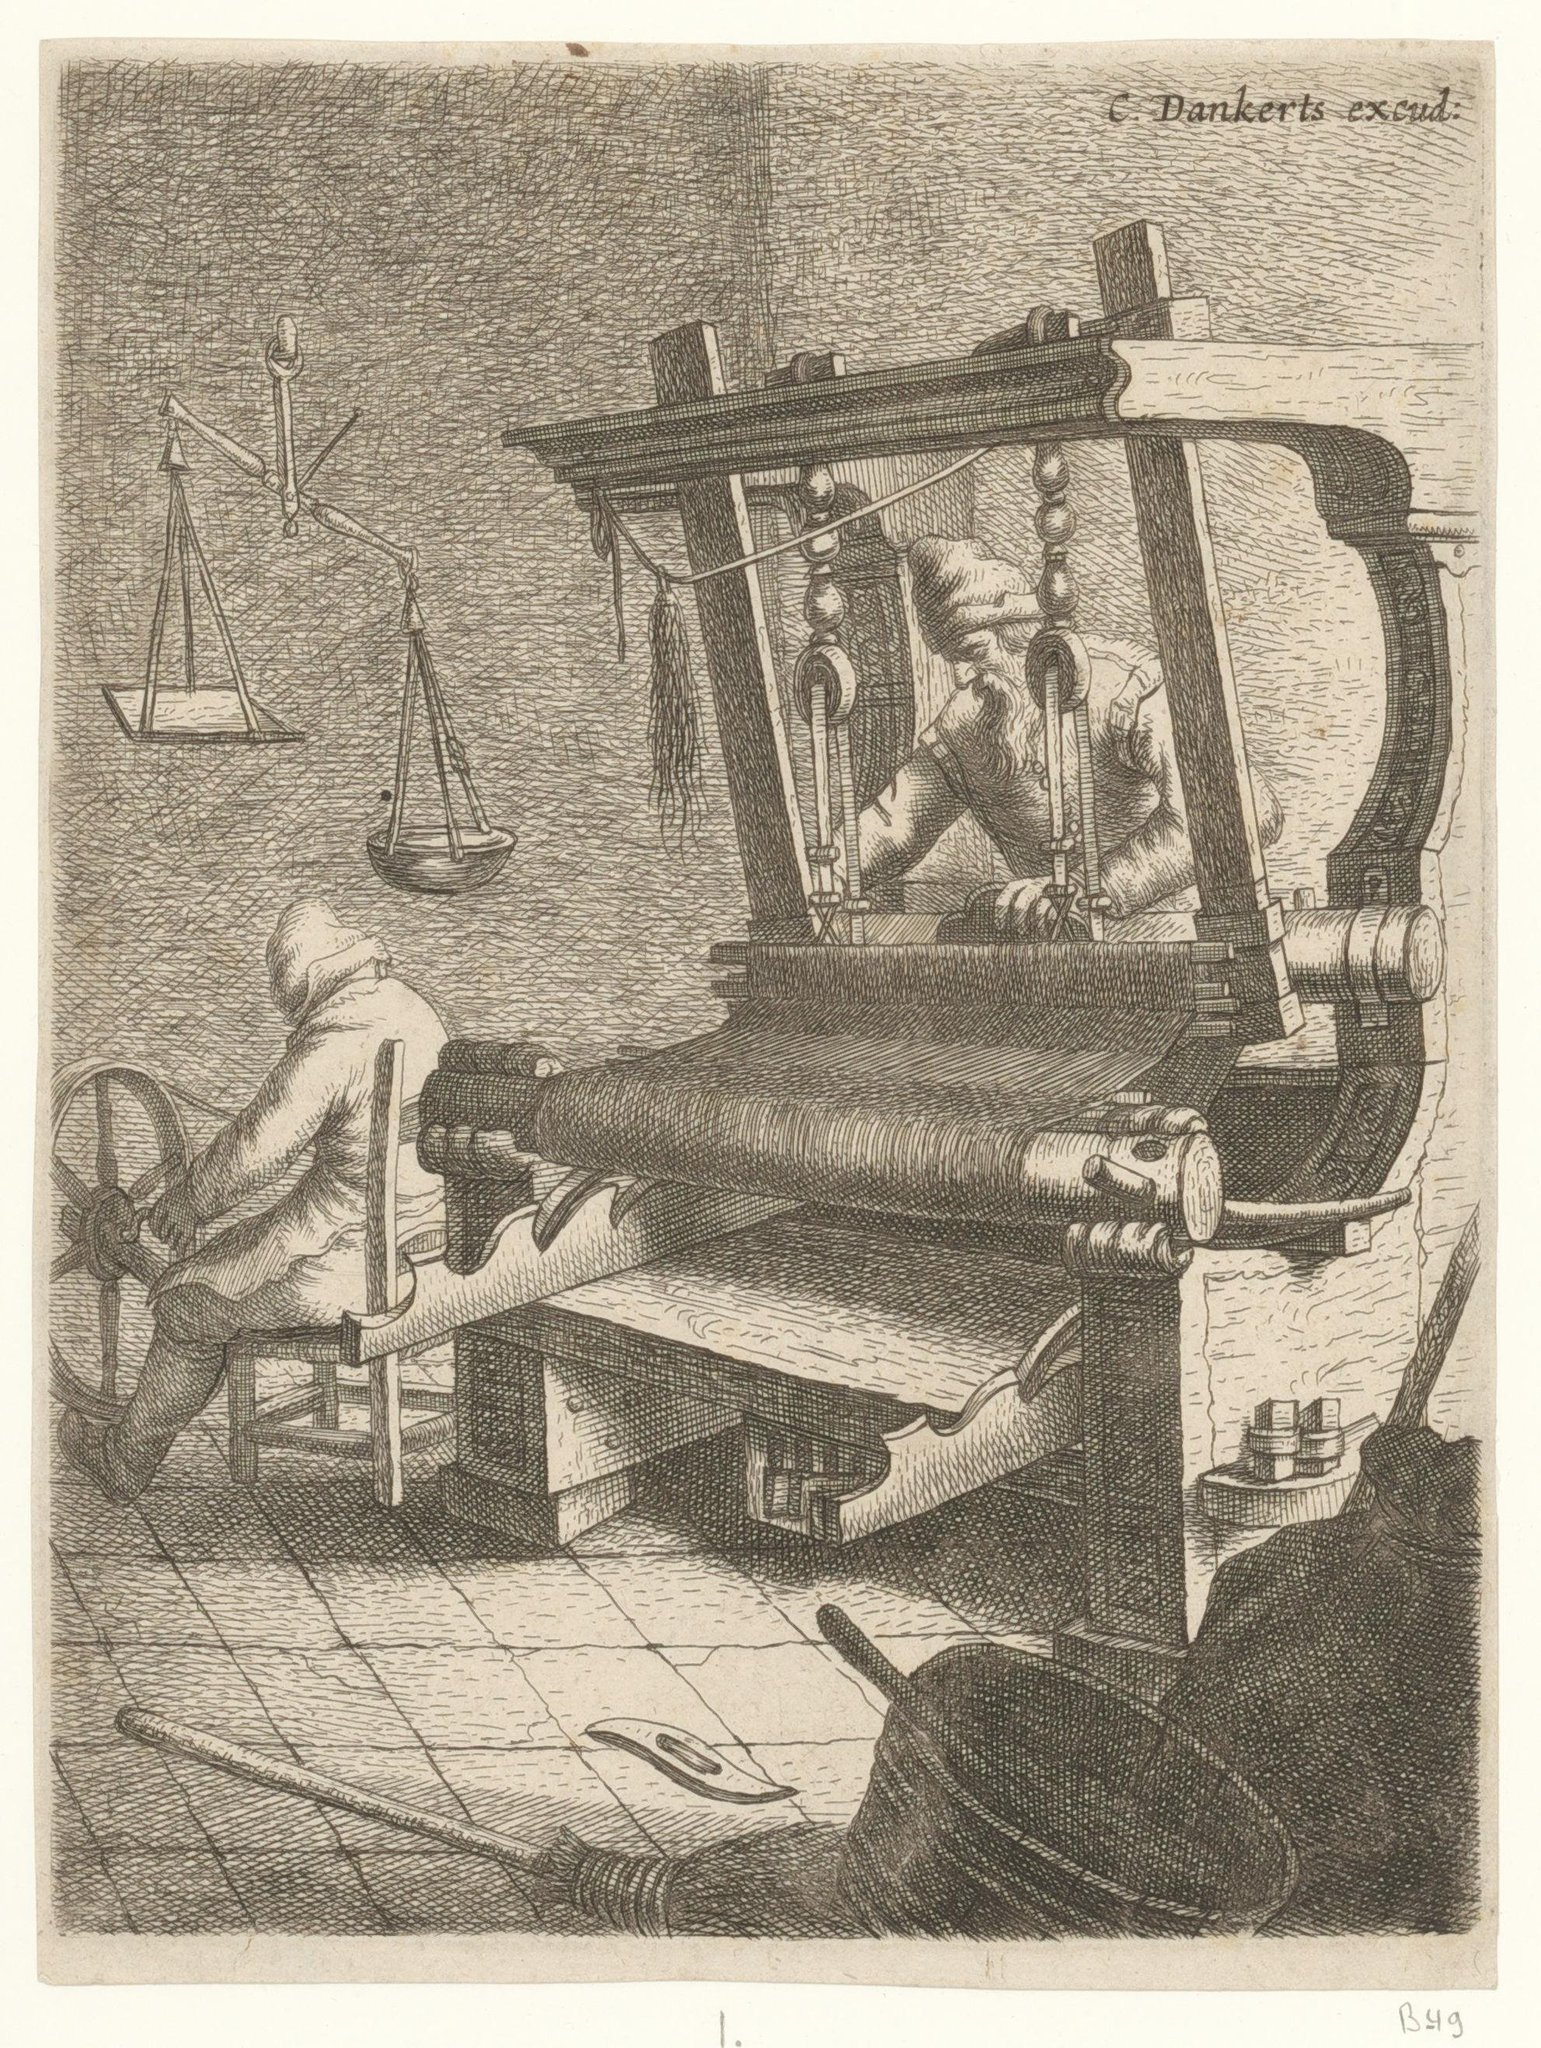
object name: print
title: Wevers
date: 1635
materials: paper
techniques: etching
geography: amsterdam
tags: handicrafts, craftsman at work, scales, weaving-loom, weaving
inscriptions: stamp, collector's mark: Lugt 1641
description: Wevers in een werkplaats. Een man staat achter een weefgetouw en links zit een man bij een vliegwiel. Aan de wand hangt een balans. Onderwerpsrubrieken binnen de Atlas Zeden en Gewoonten: Handel, Nijverheid en Verkeer, Beroep en bedrijf, Complete suites.